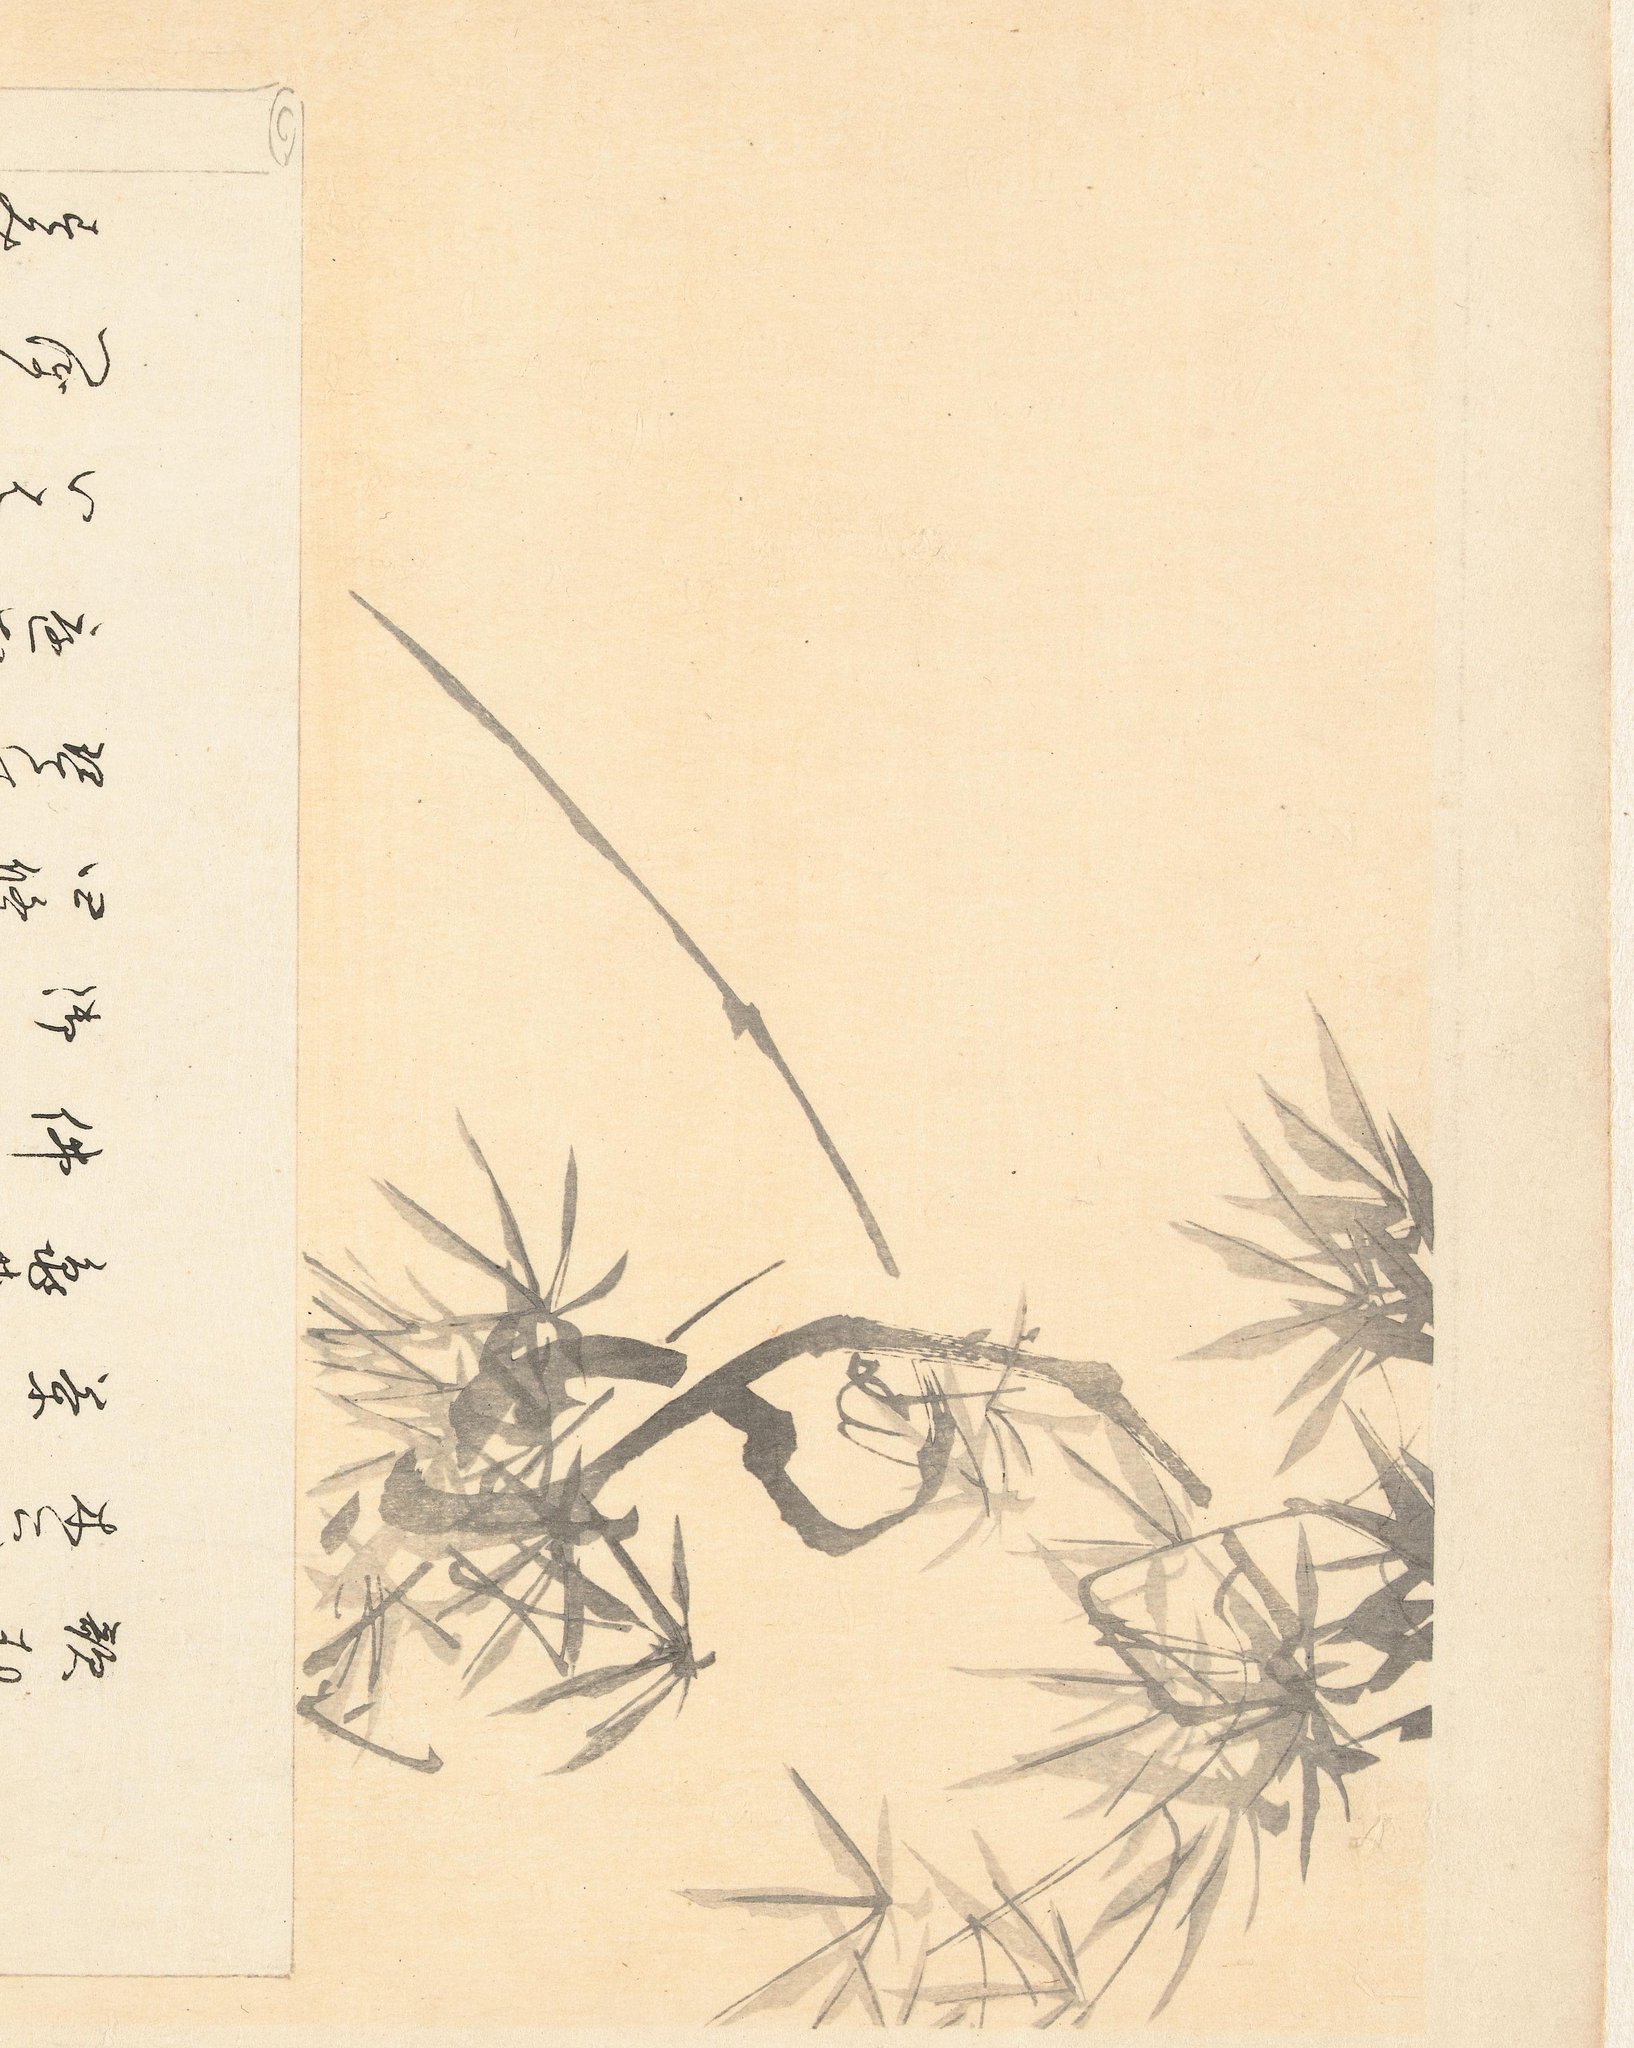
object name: print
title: Fujin fuzoku zukushi mokuroku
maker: ogata gekkô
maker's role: painter, print maker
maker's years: 1859-1920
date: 1898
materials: paper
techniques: blind stamped, woodcut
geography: japan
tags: plants (in general) (+ branch, stick)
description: De titels voor elk van de 36 prenten uit de serie Fujin fuzoku zukushi mokuroku, in het Japans, in een vierkant wit cartouche, tegen een gele achtergrond met bamboe takken.